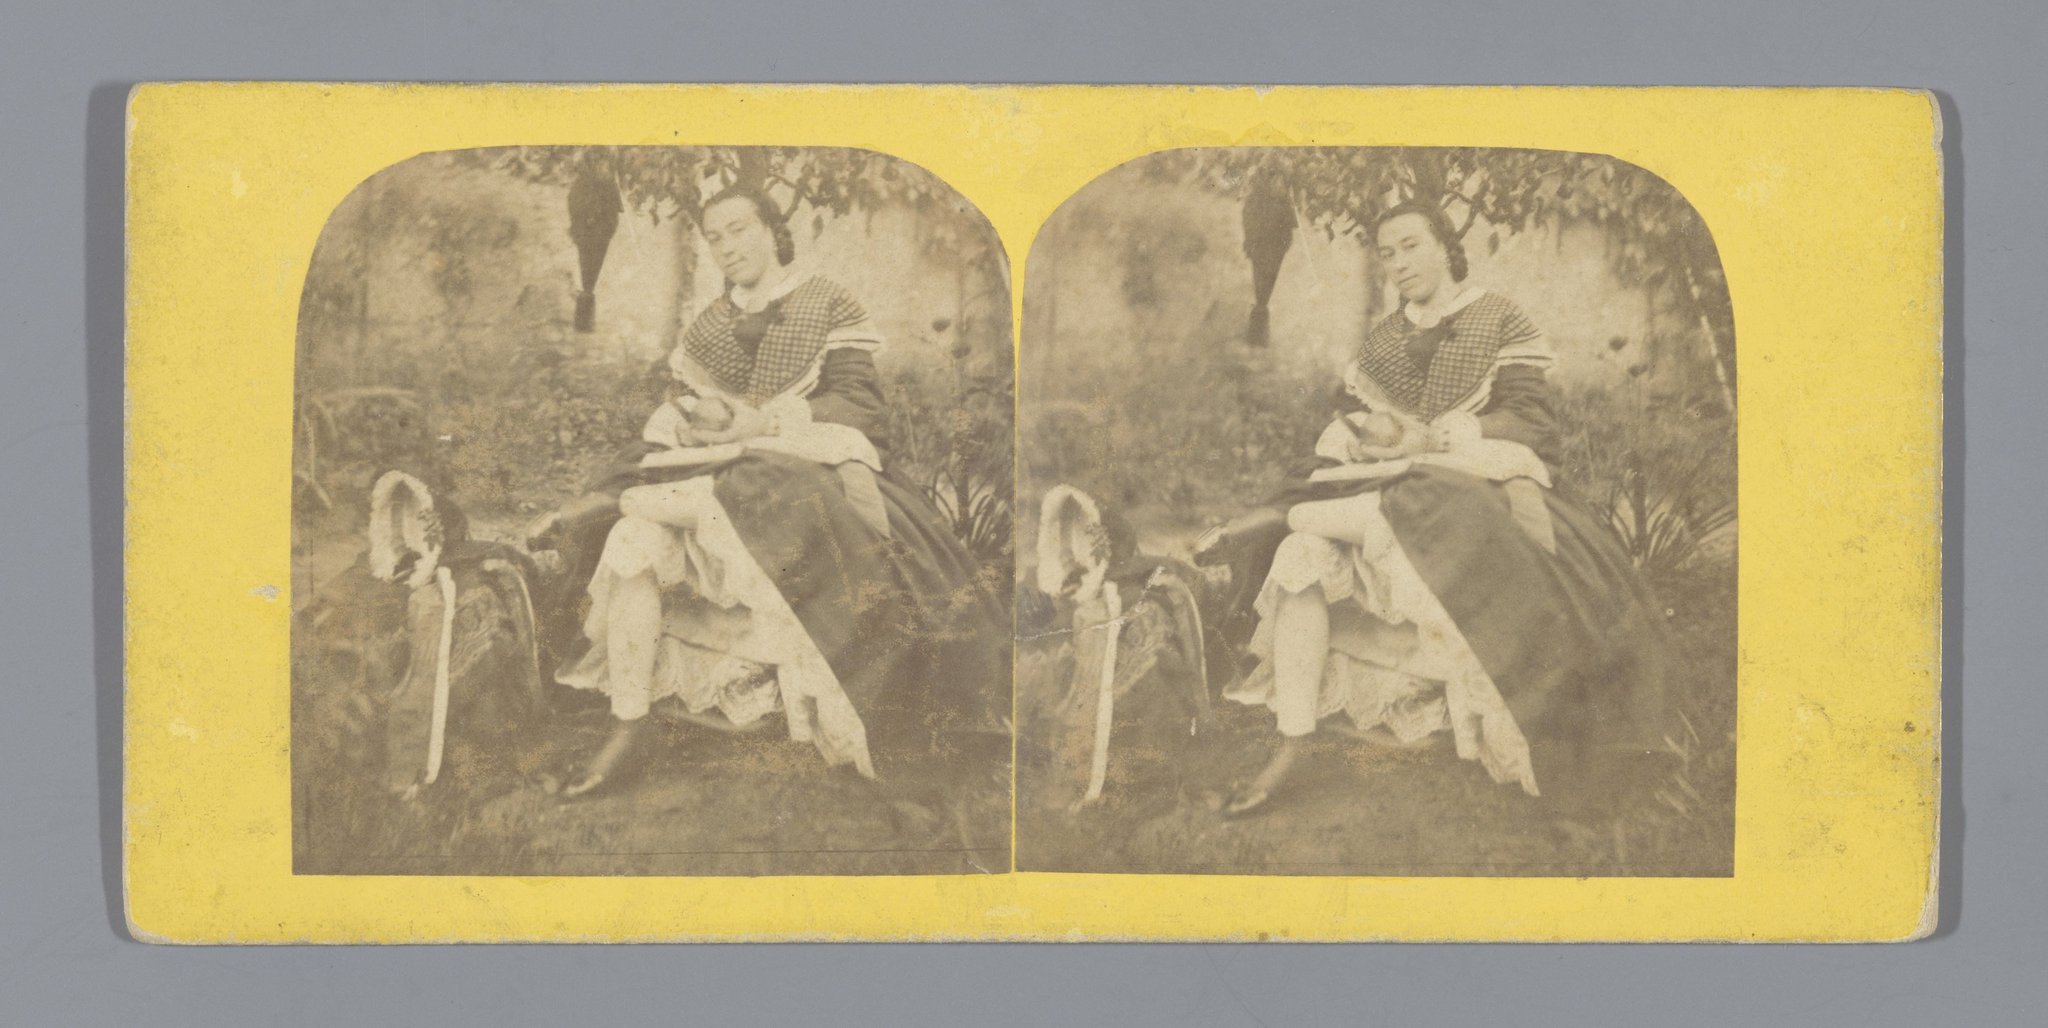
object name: stereograph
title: Vrouw schilt een appel onder een boom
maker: Anonymous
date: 1850-1880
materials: cardboard, photographic support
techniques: albumen print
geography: europe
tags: cleaning fruit, e.g. peeling, europe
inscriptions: number: ‘40’